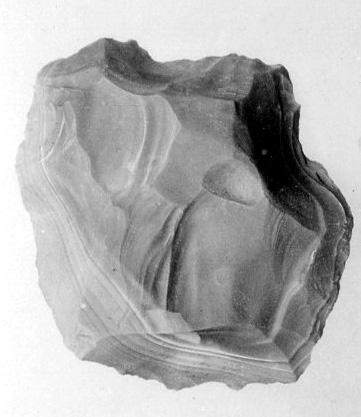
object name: tool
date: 1295-1070 BCE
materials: stone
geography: egypt